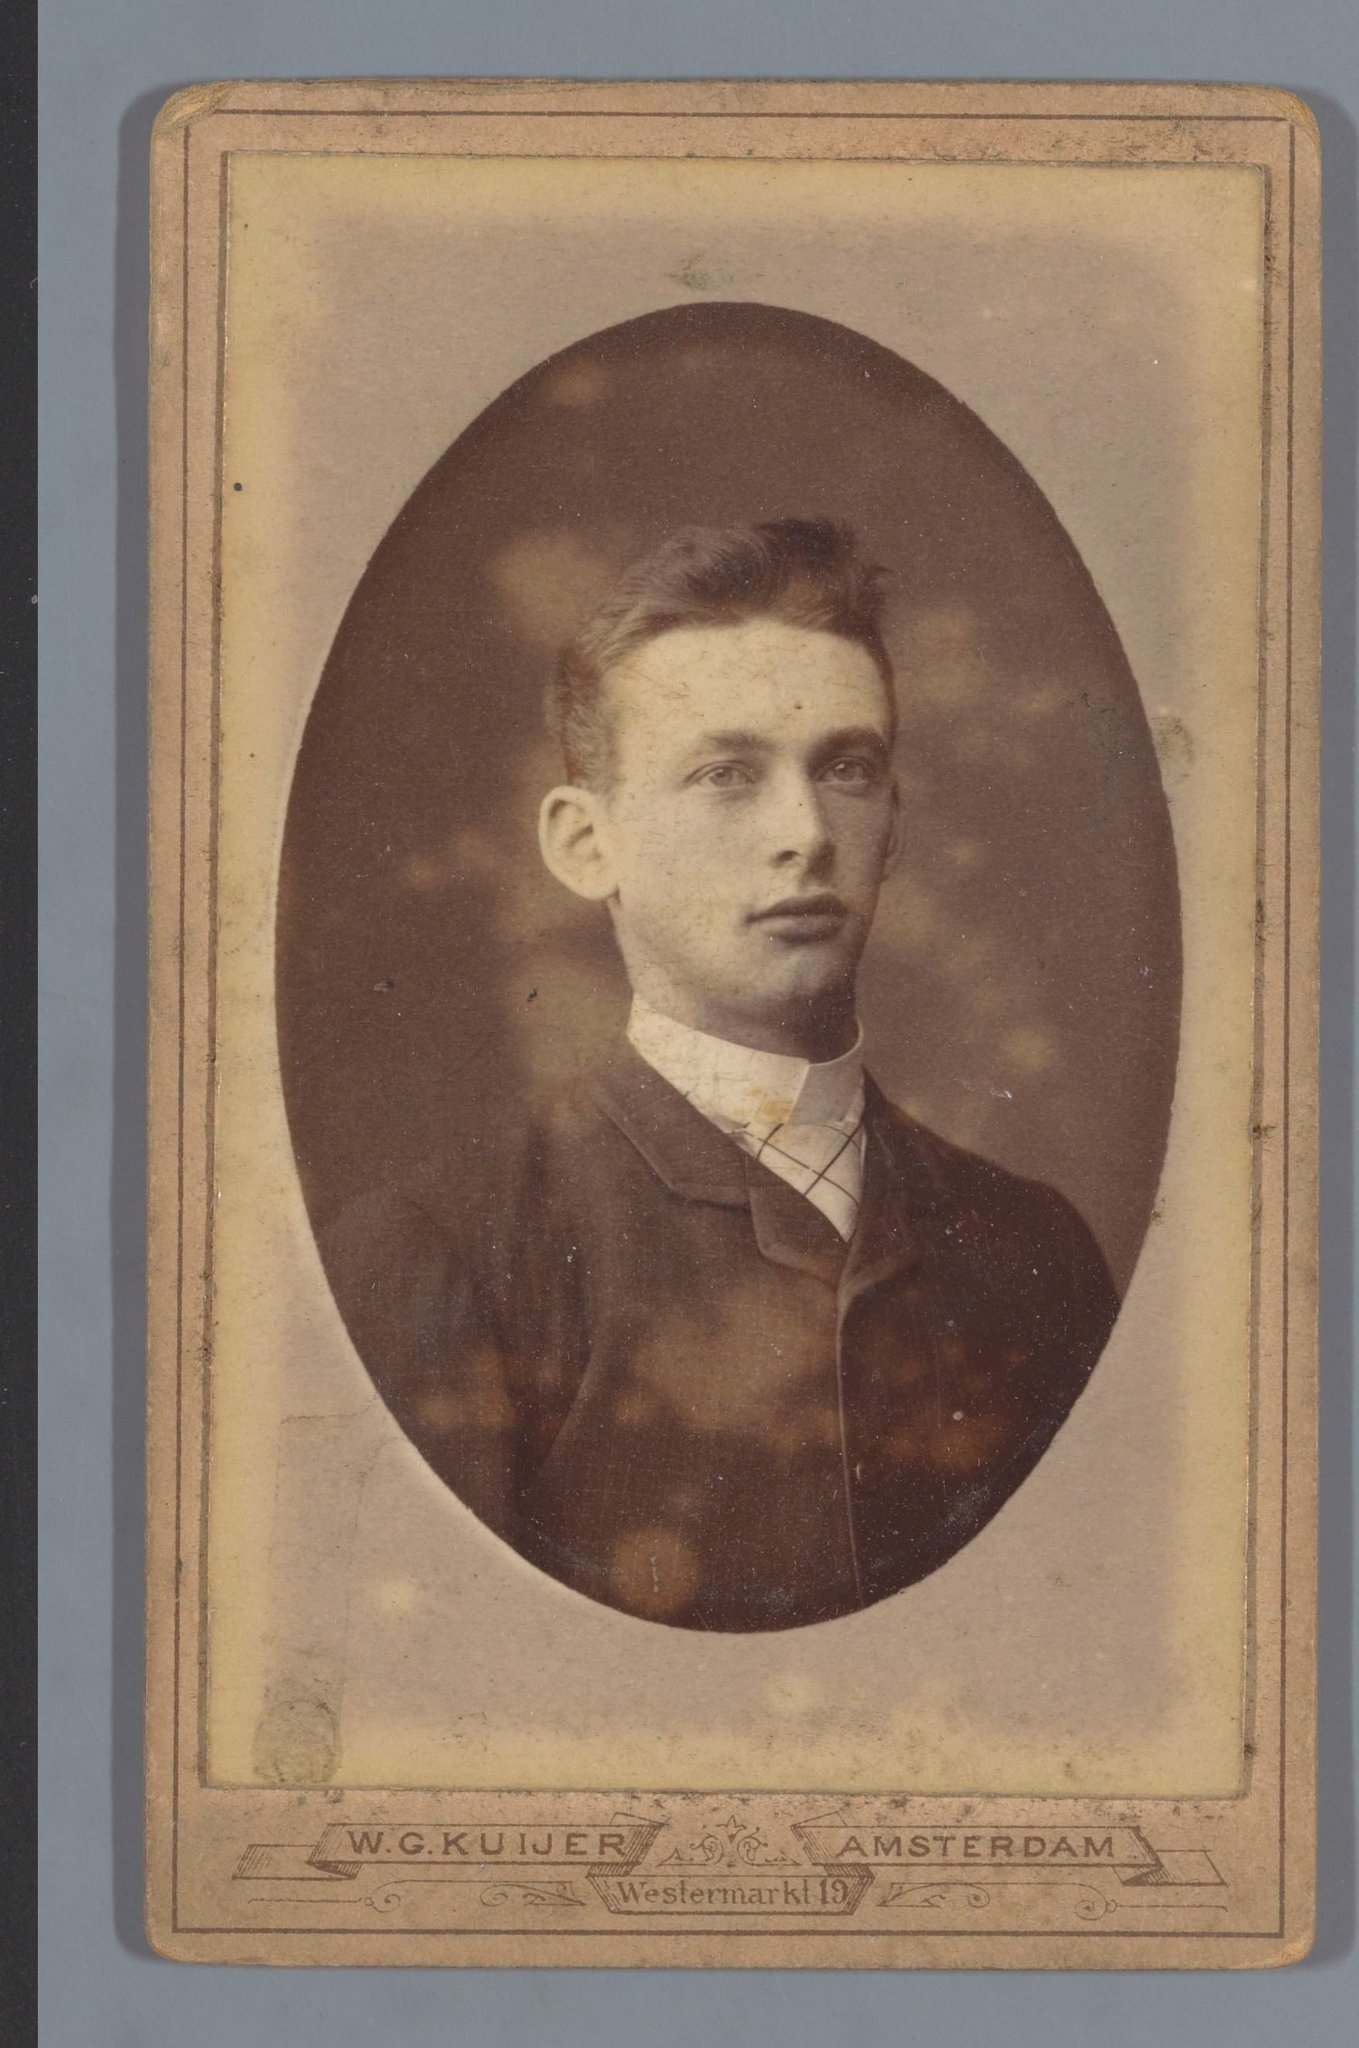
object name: carte de visite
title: Portret van een onbekende man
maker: willem gerhardus kuijer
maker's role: fotograaf, hoffotograaf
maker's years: 1834-1899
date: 1862-1899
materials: cardboard, paper, photographic support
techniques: albumen print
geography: amsterdam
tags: adult man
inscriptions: inscription: ‘Amsterdam W.G. Kuijer Westermarkt 19.’, name: ‘W.G. Kuijer Westermarkt 19 Amsterdam’